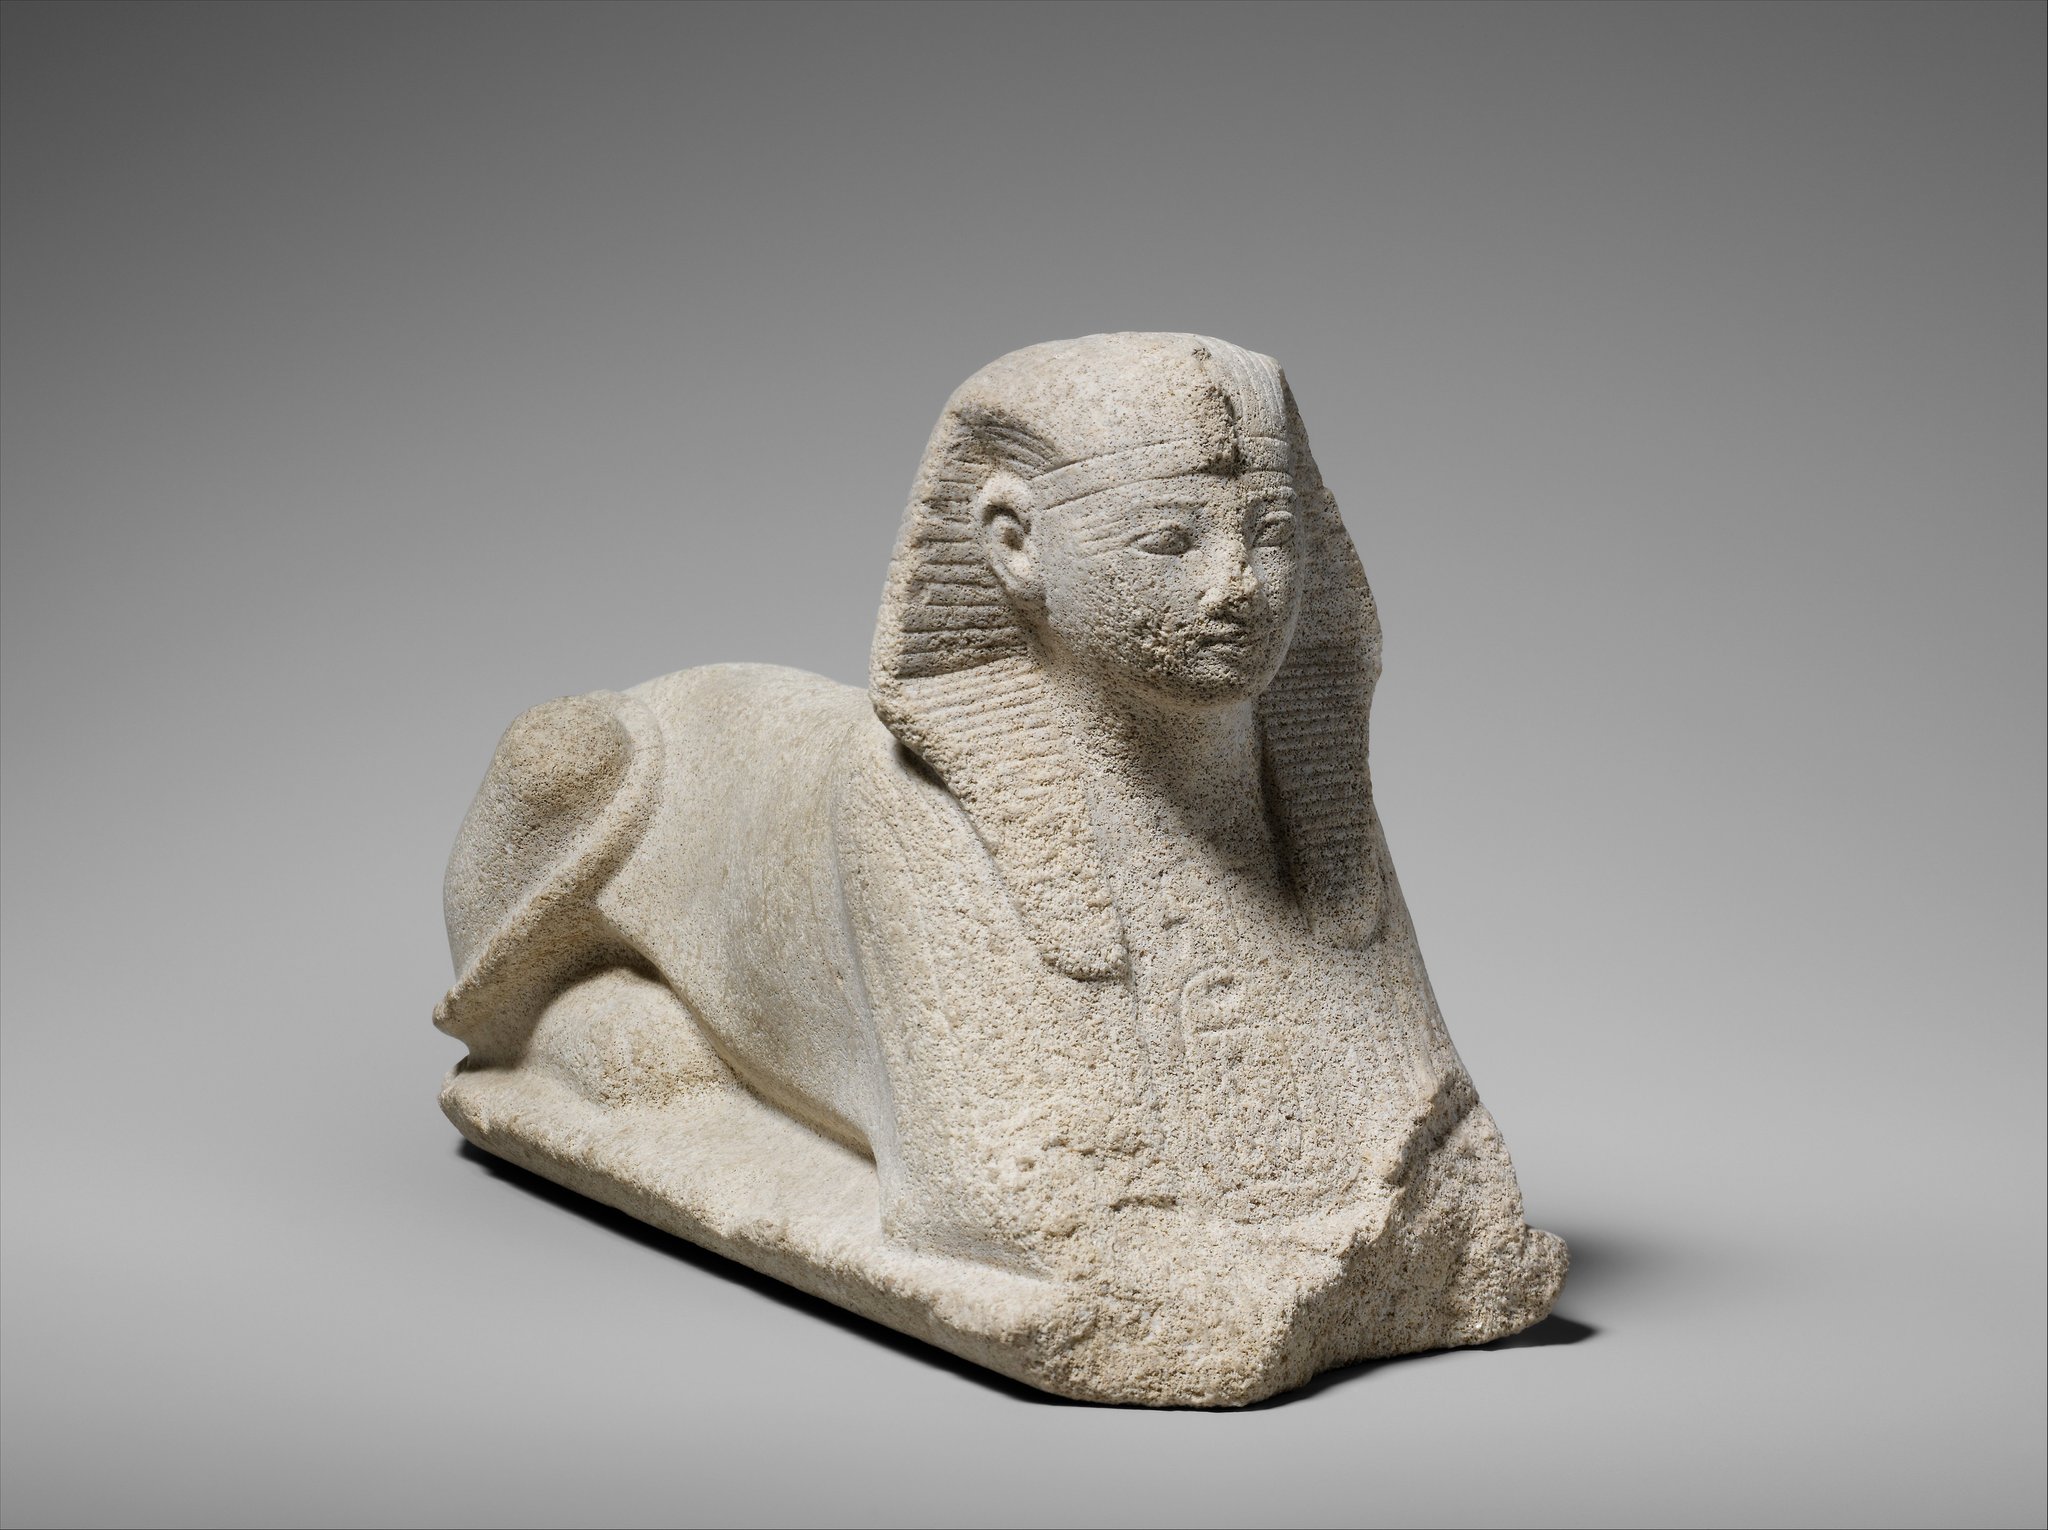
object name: sphinx, amenhotep ii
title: Sphinx of Amenhotep II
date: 1427-1400 BCE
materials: stone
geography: upper egypt, thebes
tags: sphinx